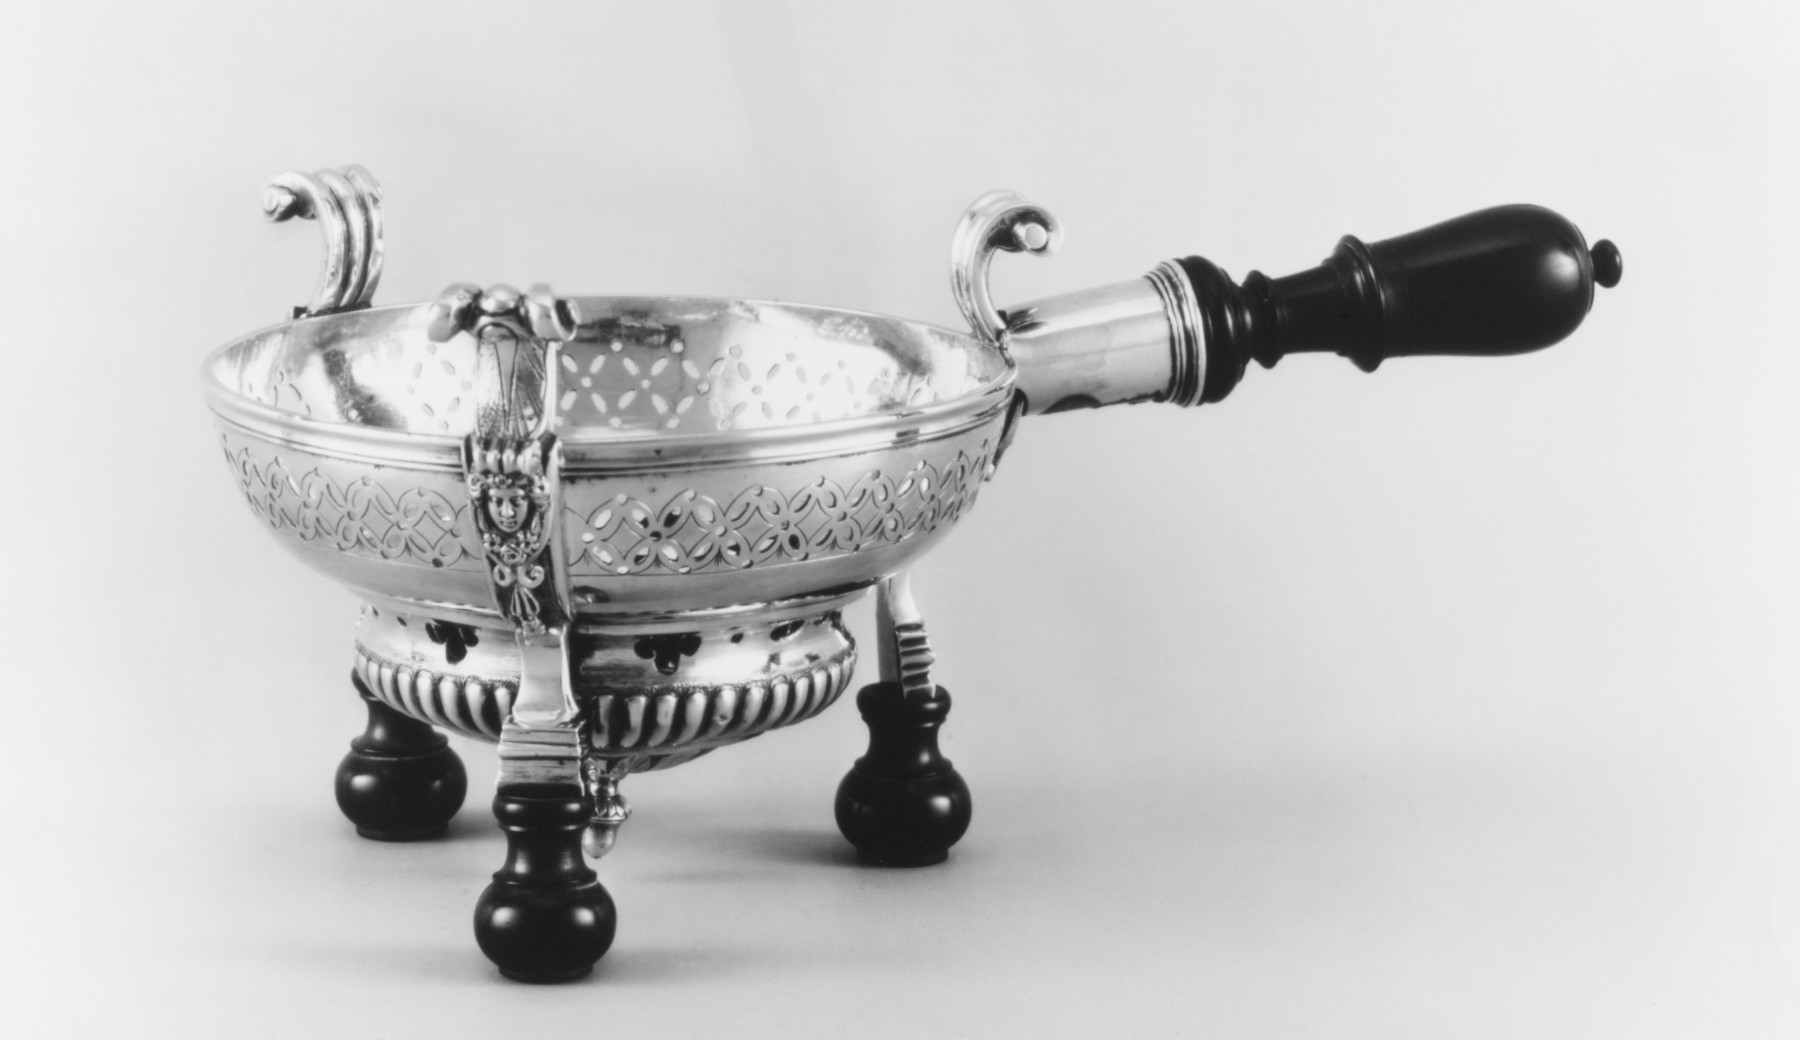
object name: brazier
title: Brazier (one of a pair)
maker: l.b.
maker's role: maker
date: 1701-1725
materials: wood, silver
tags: faces